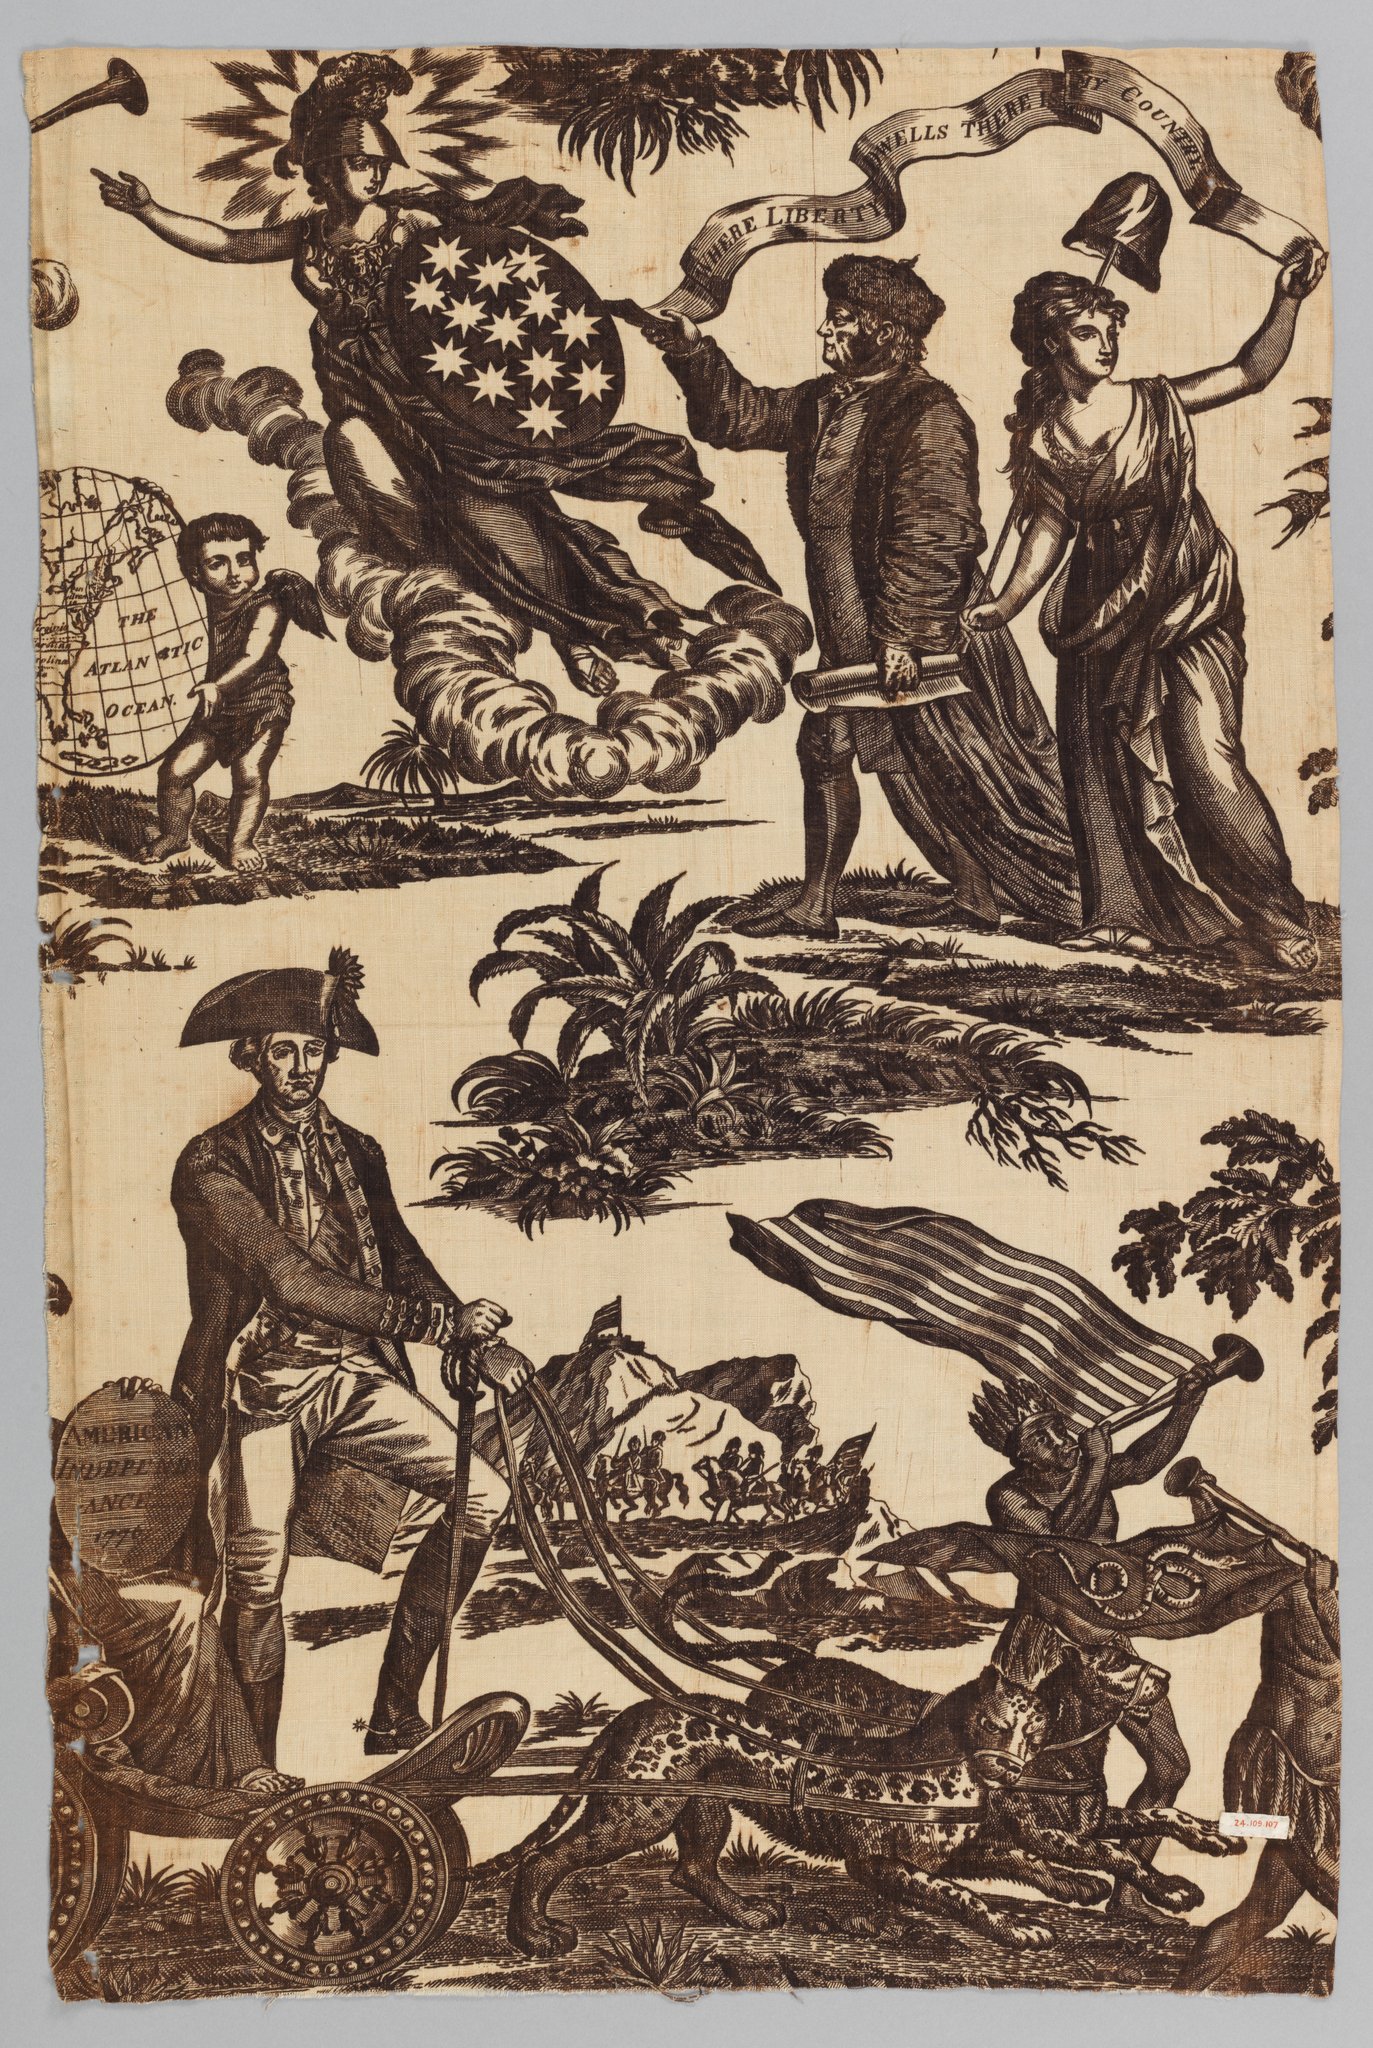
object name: piece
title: Apotheosis of Franklin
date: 1790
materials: cotton, linen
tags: benjamin franklin,men,women,leopards,flags